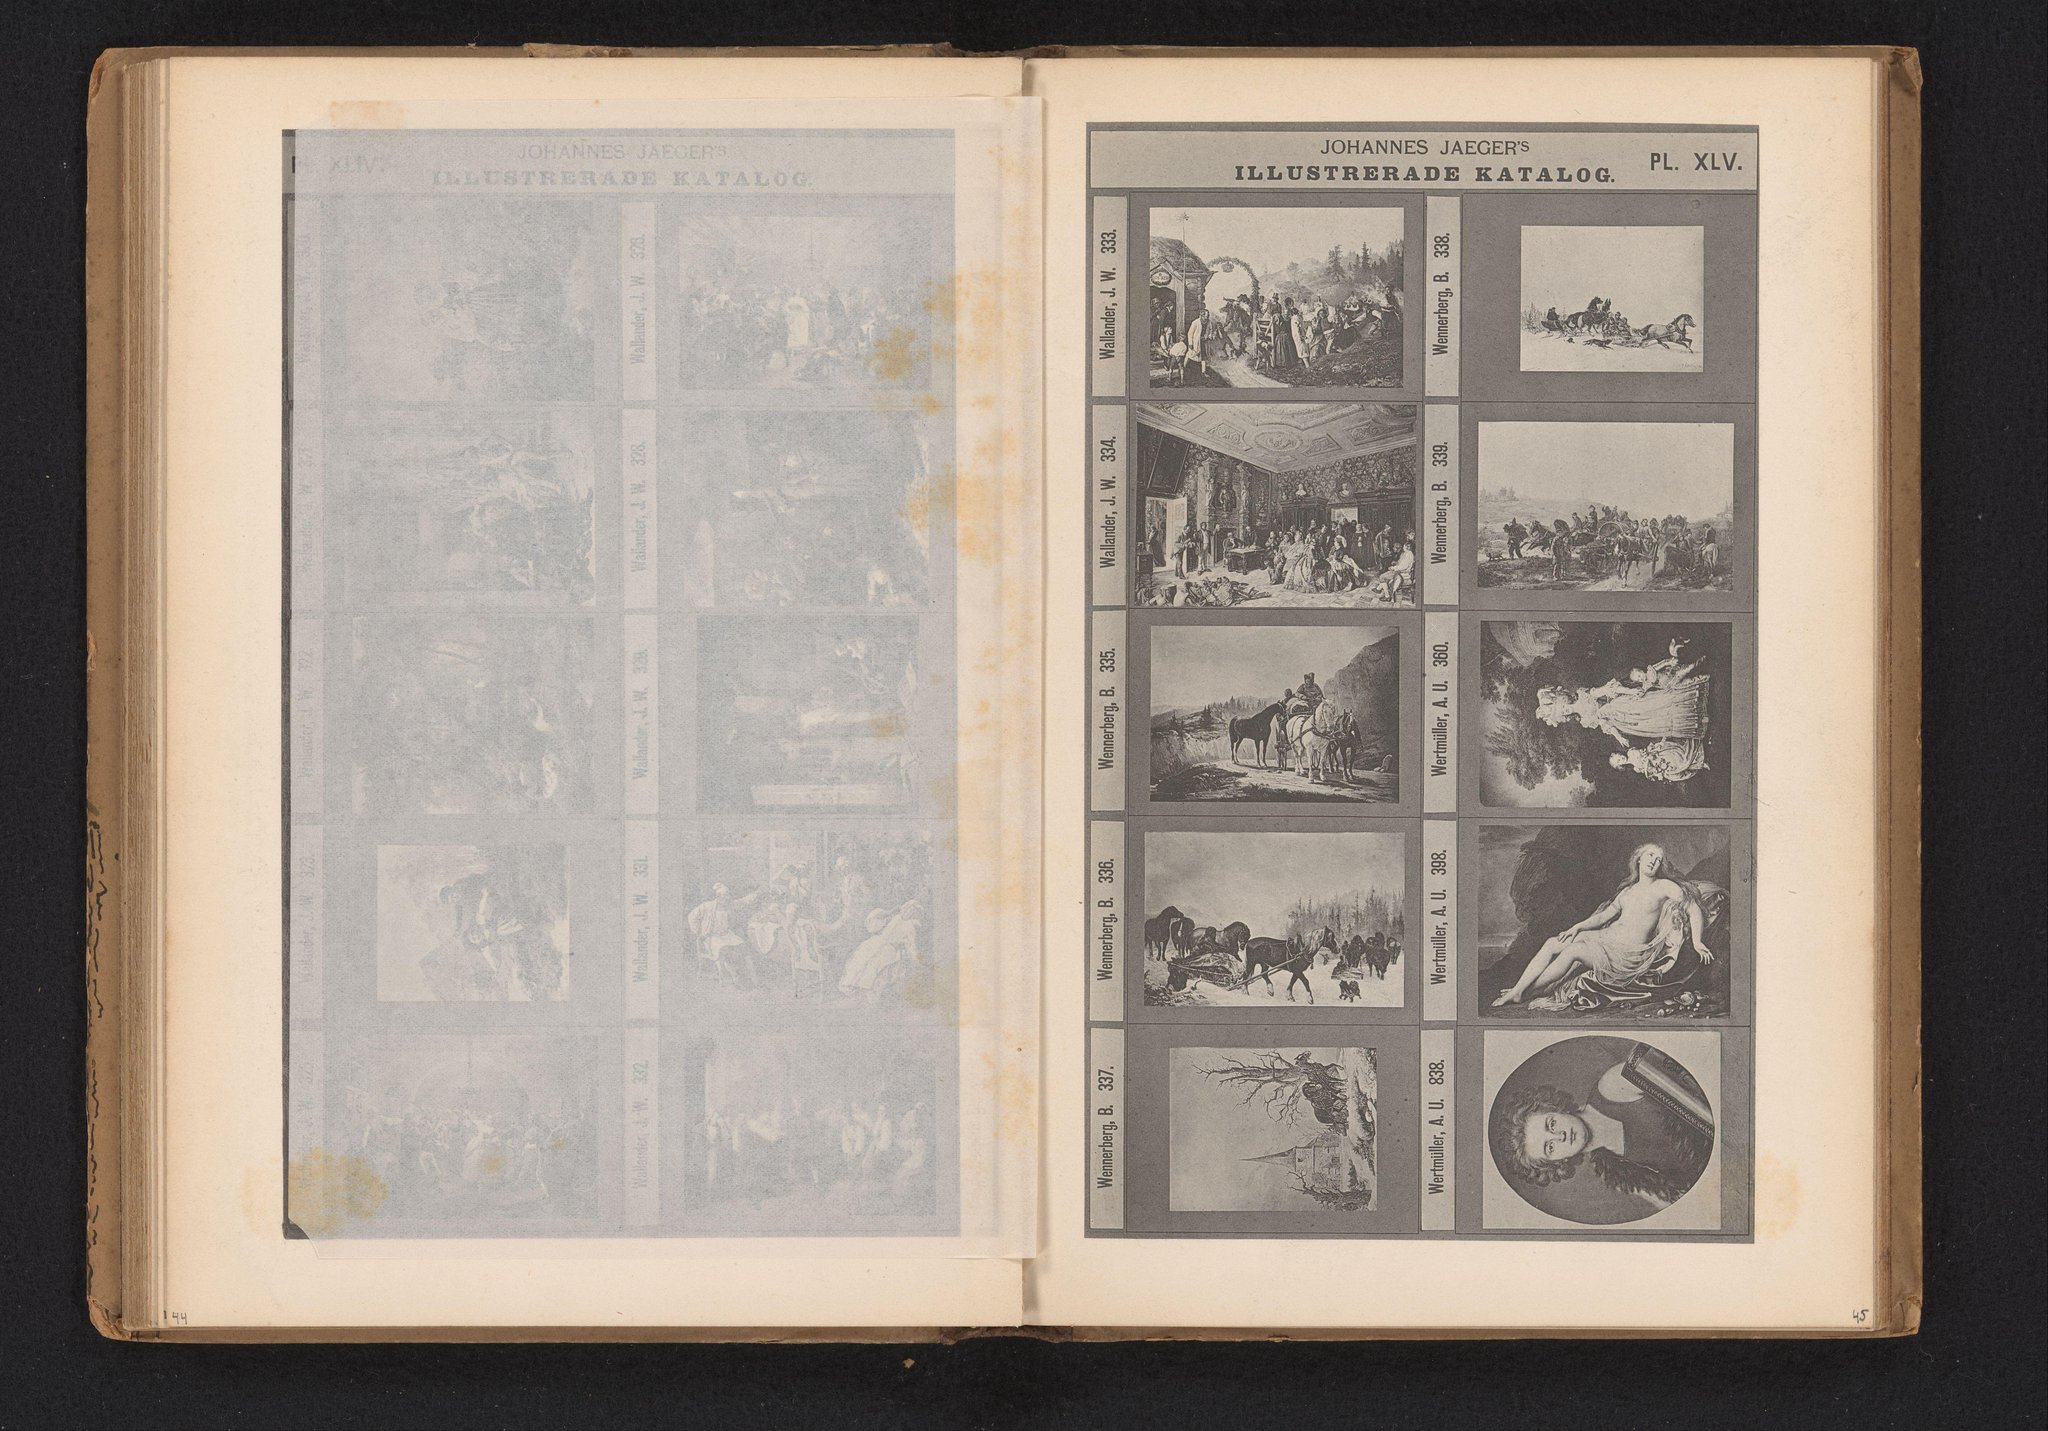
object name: reproduction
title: Johannes Jaeger's Illustrerade Katalog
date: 1872-1882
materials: paper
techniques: photograph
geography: stockholm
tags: picture, painting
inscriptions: number: ‘PL. XLV.’